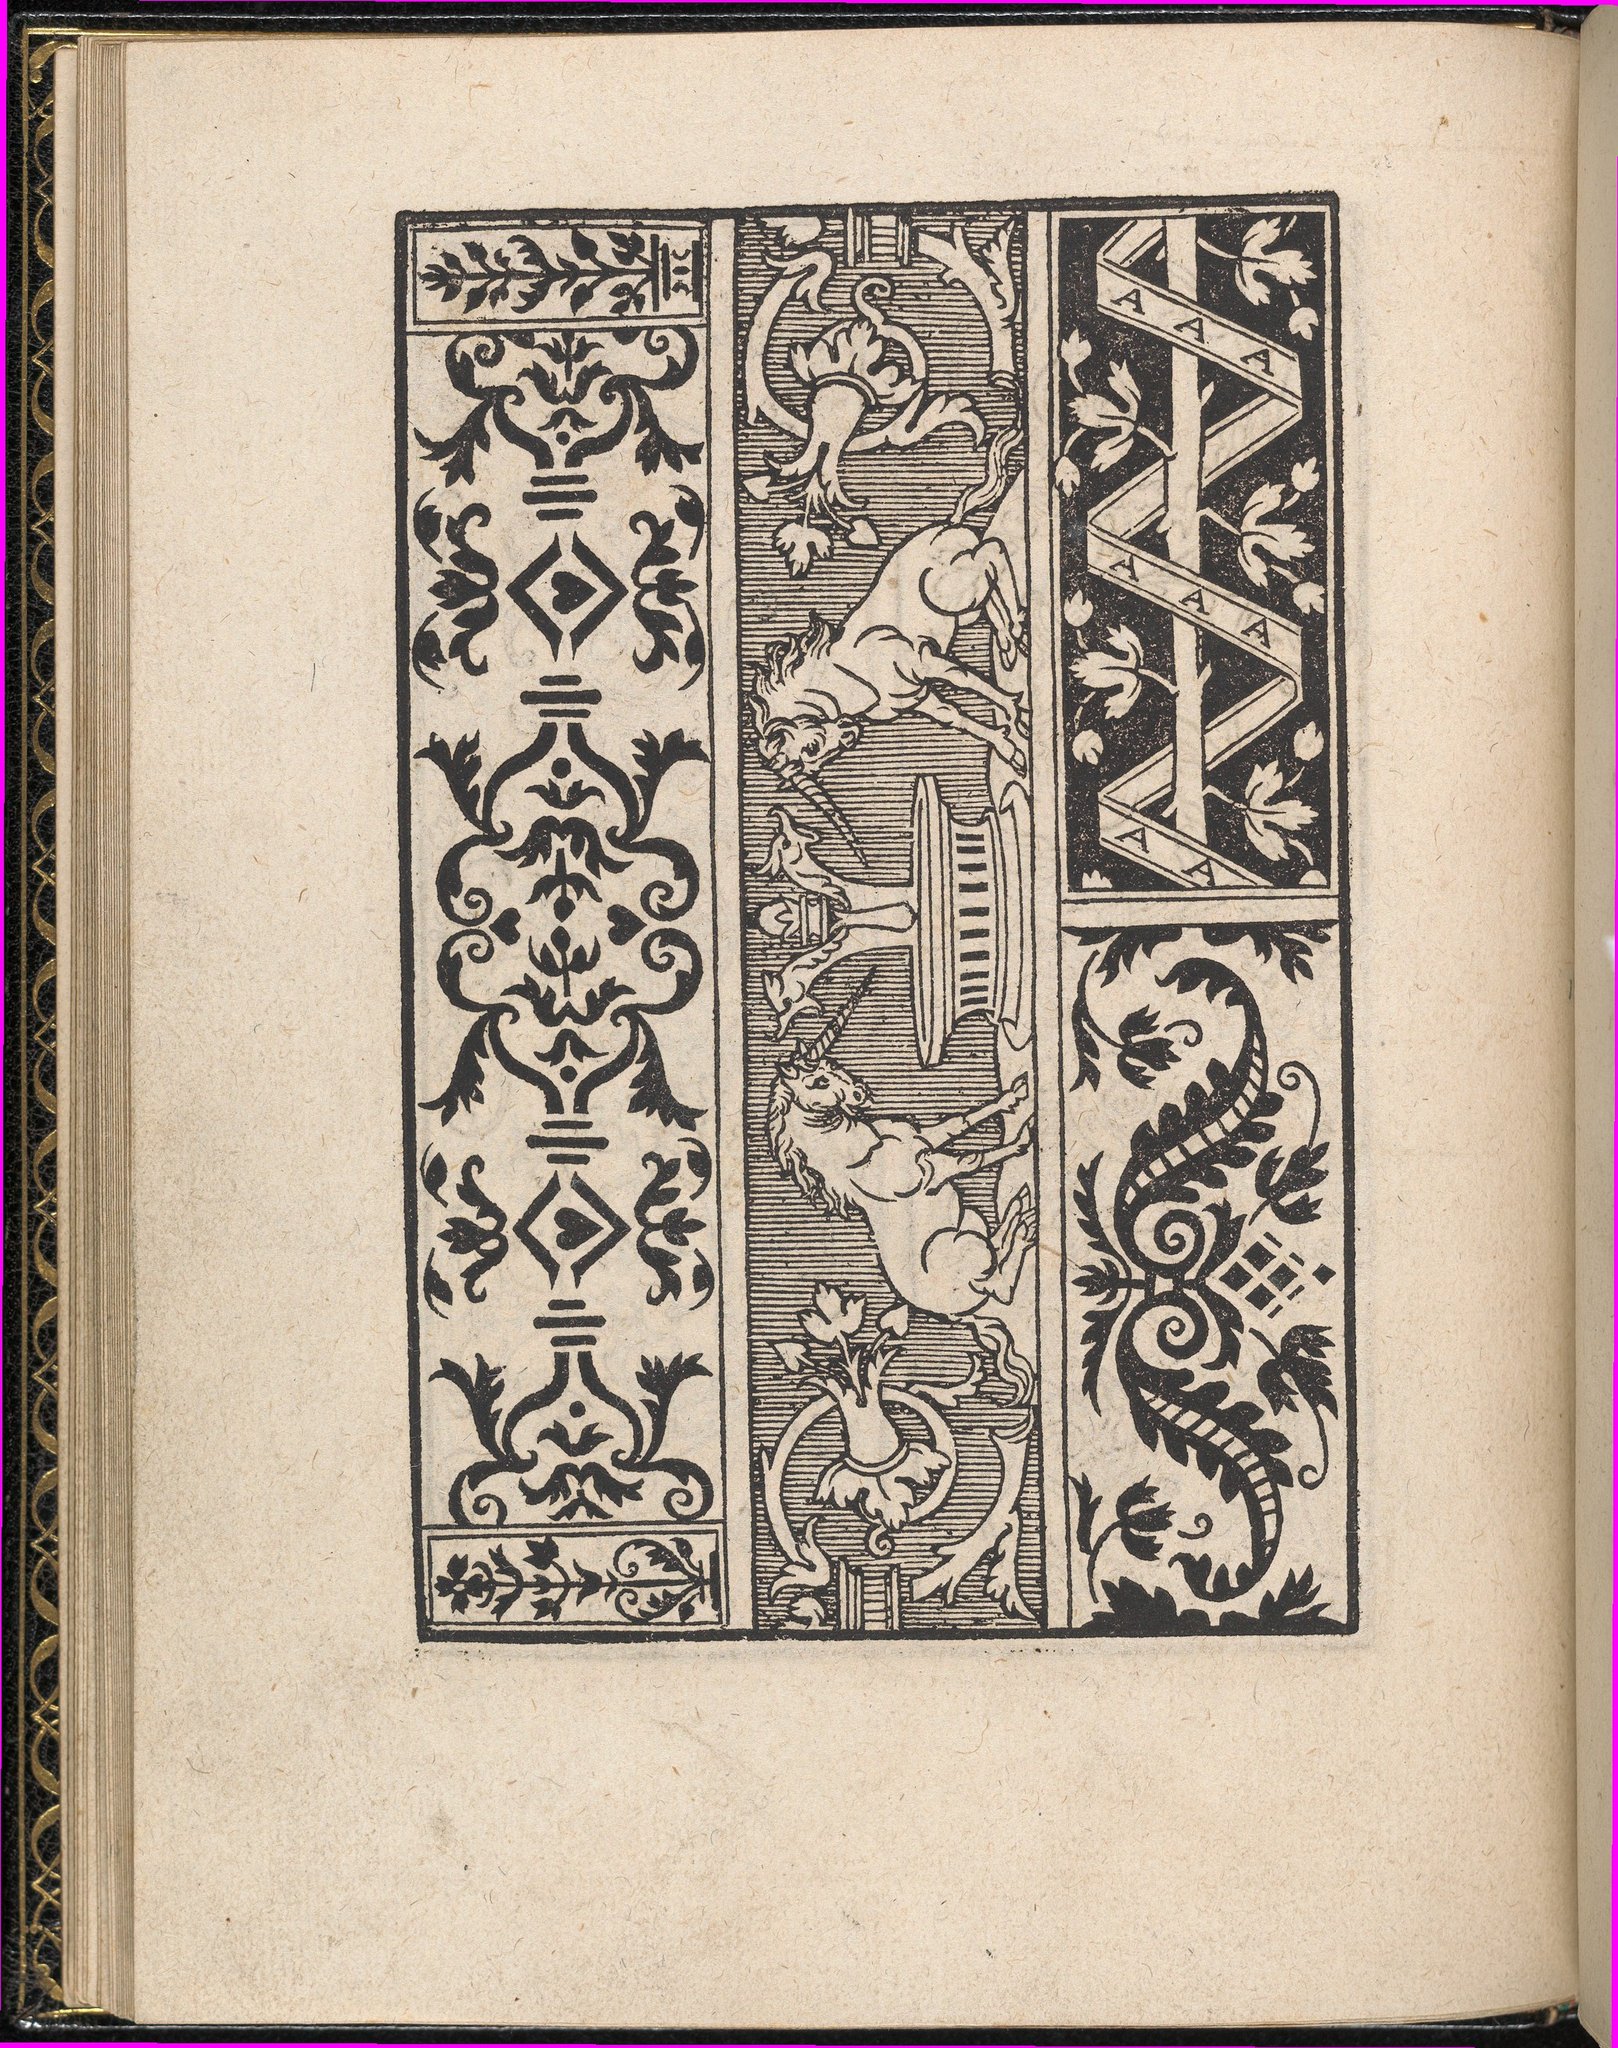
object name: book print ornament architecture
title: Page from Ein new kunstlich Modelbuch...(Page 18v)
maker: peter quentel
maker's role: publisher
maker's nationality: german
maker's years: 1500-1550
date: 1544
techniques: woodcut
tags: unicorns